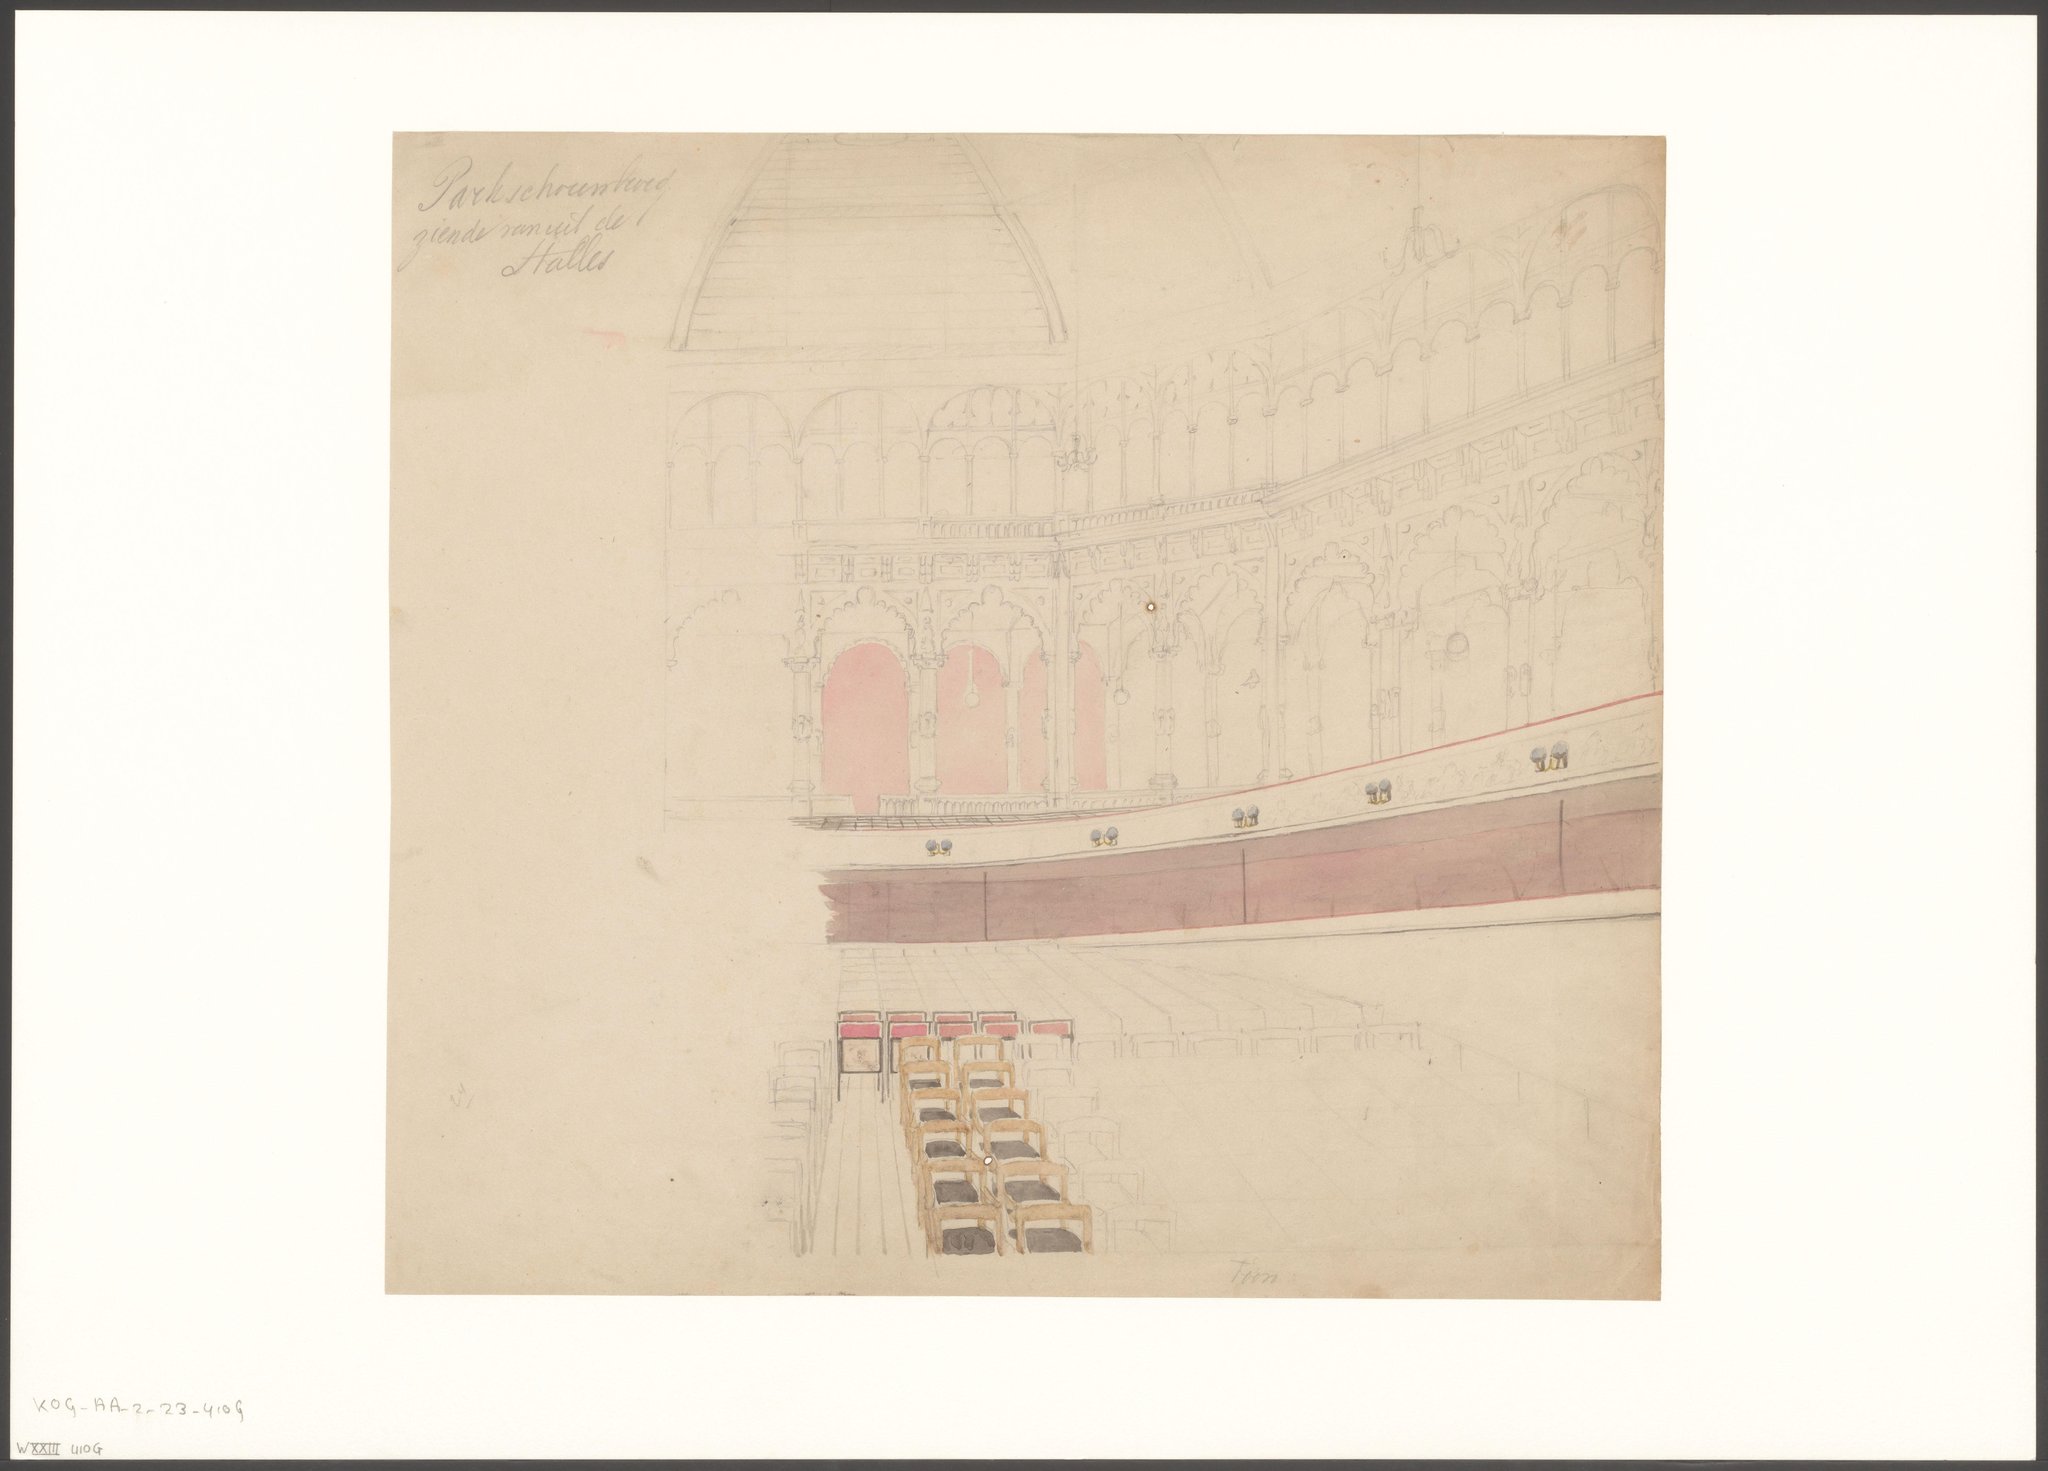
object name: drawing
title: Interieur van de Parkschouwburg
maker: johan george lodewijk rieke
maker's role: draughtsman, print maker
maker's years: 1817-1898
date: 1883-1898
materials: paper, pencil, watercolor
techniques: brush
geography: amsterdam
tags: city-view in general; 'veduta', theatre, theatrical performance, the stage and its equipment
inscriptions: inscription: ‘Parkschouwburg / ziende van uit / Halles / Toon’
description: Tekening binnen de Atlas Van Eck ingedeeld op wijknummer 23.